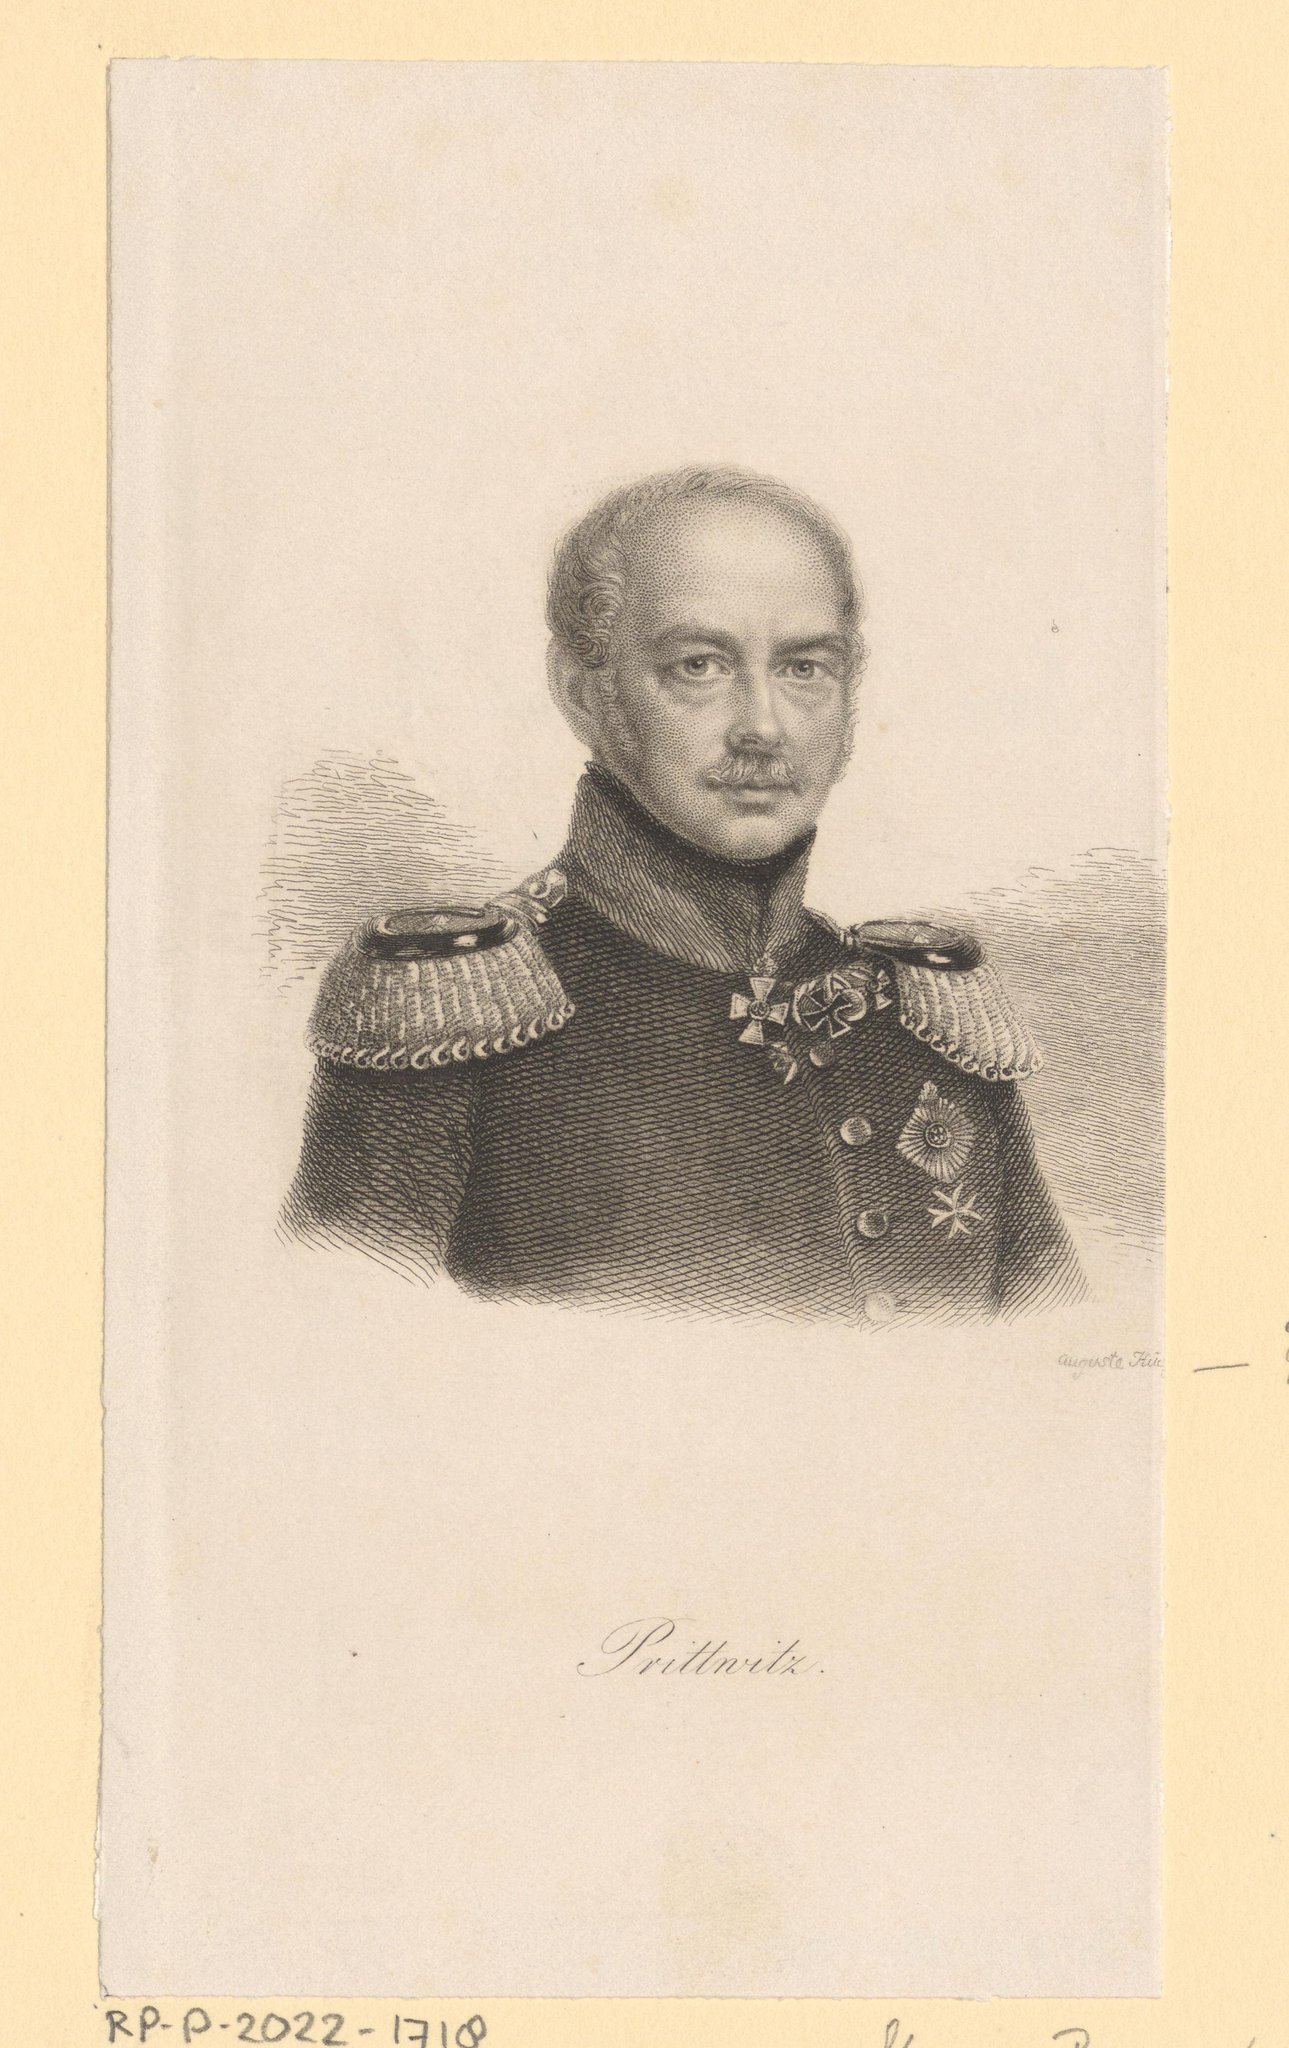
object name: print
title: Portret van Karl Prittwitz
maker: auguste hüssener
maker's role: print maker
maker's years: 1789-1877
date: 1835-1877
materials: paper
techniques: roulette, engraving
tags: commander-in-chief, general, marshal, historical persons, medals and other marks of military honour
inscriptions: inscription: ‘Karl Ludwig Wilhelm Ernst / v Prittwitz’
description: Op andere exemplaren van de prent is Eduard von Bonin naast Karl Prittwitz afgebeeld. Op dit exemplaar is zijn portret afgesneden.